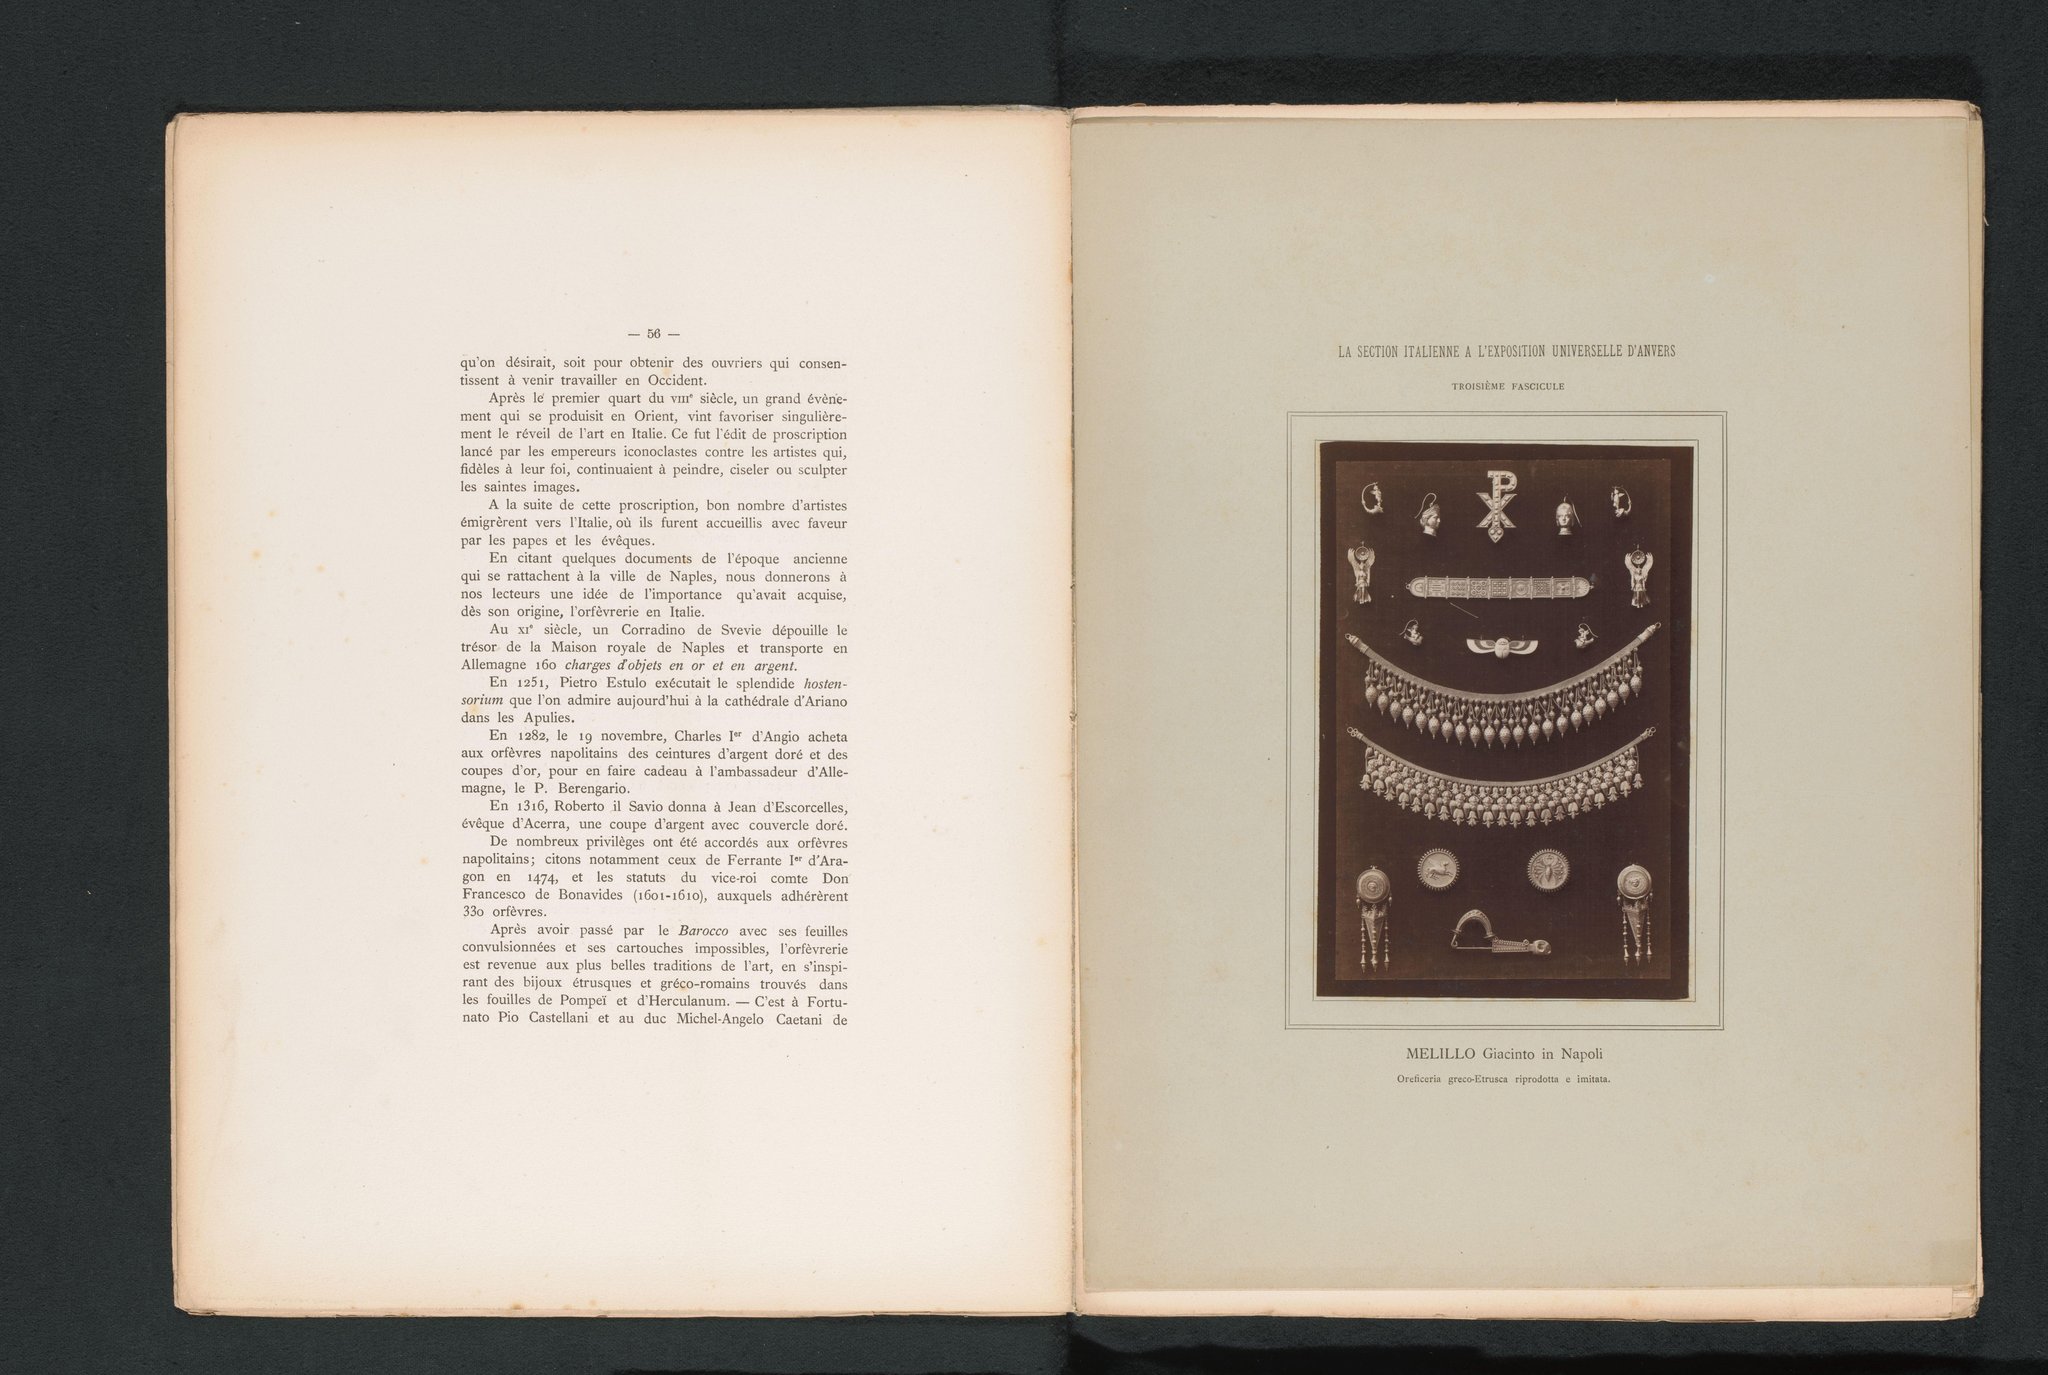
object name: page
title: Melillo Giacinto in Napoli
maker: Anonymous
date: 1880-1885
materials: photographic support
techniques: albumen print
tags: necklace, ear-rings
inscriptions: inscription: ‘Oreficeria greco-Etrusca riprodotta e imitata.’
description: Foto op losse plaat tegenover pagina 56.